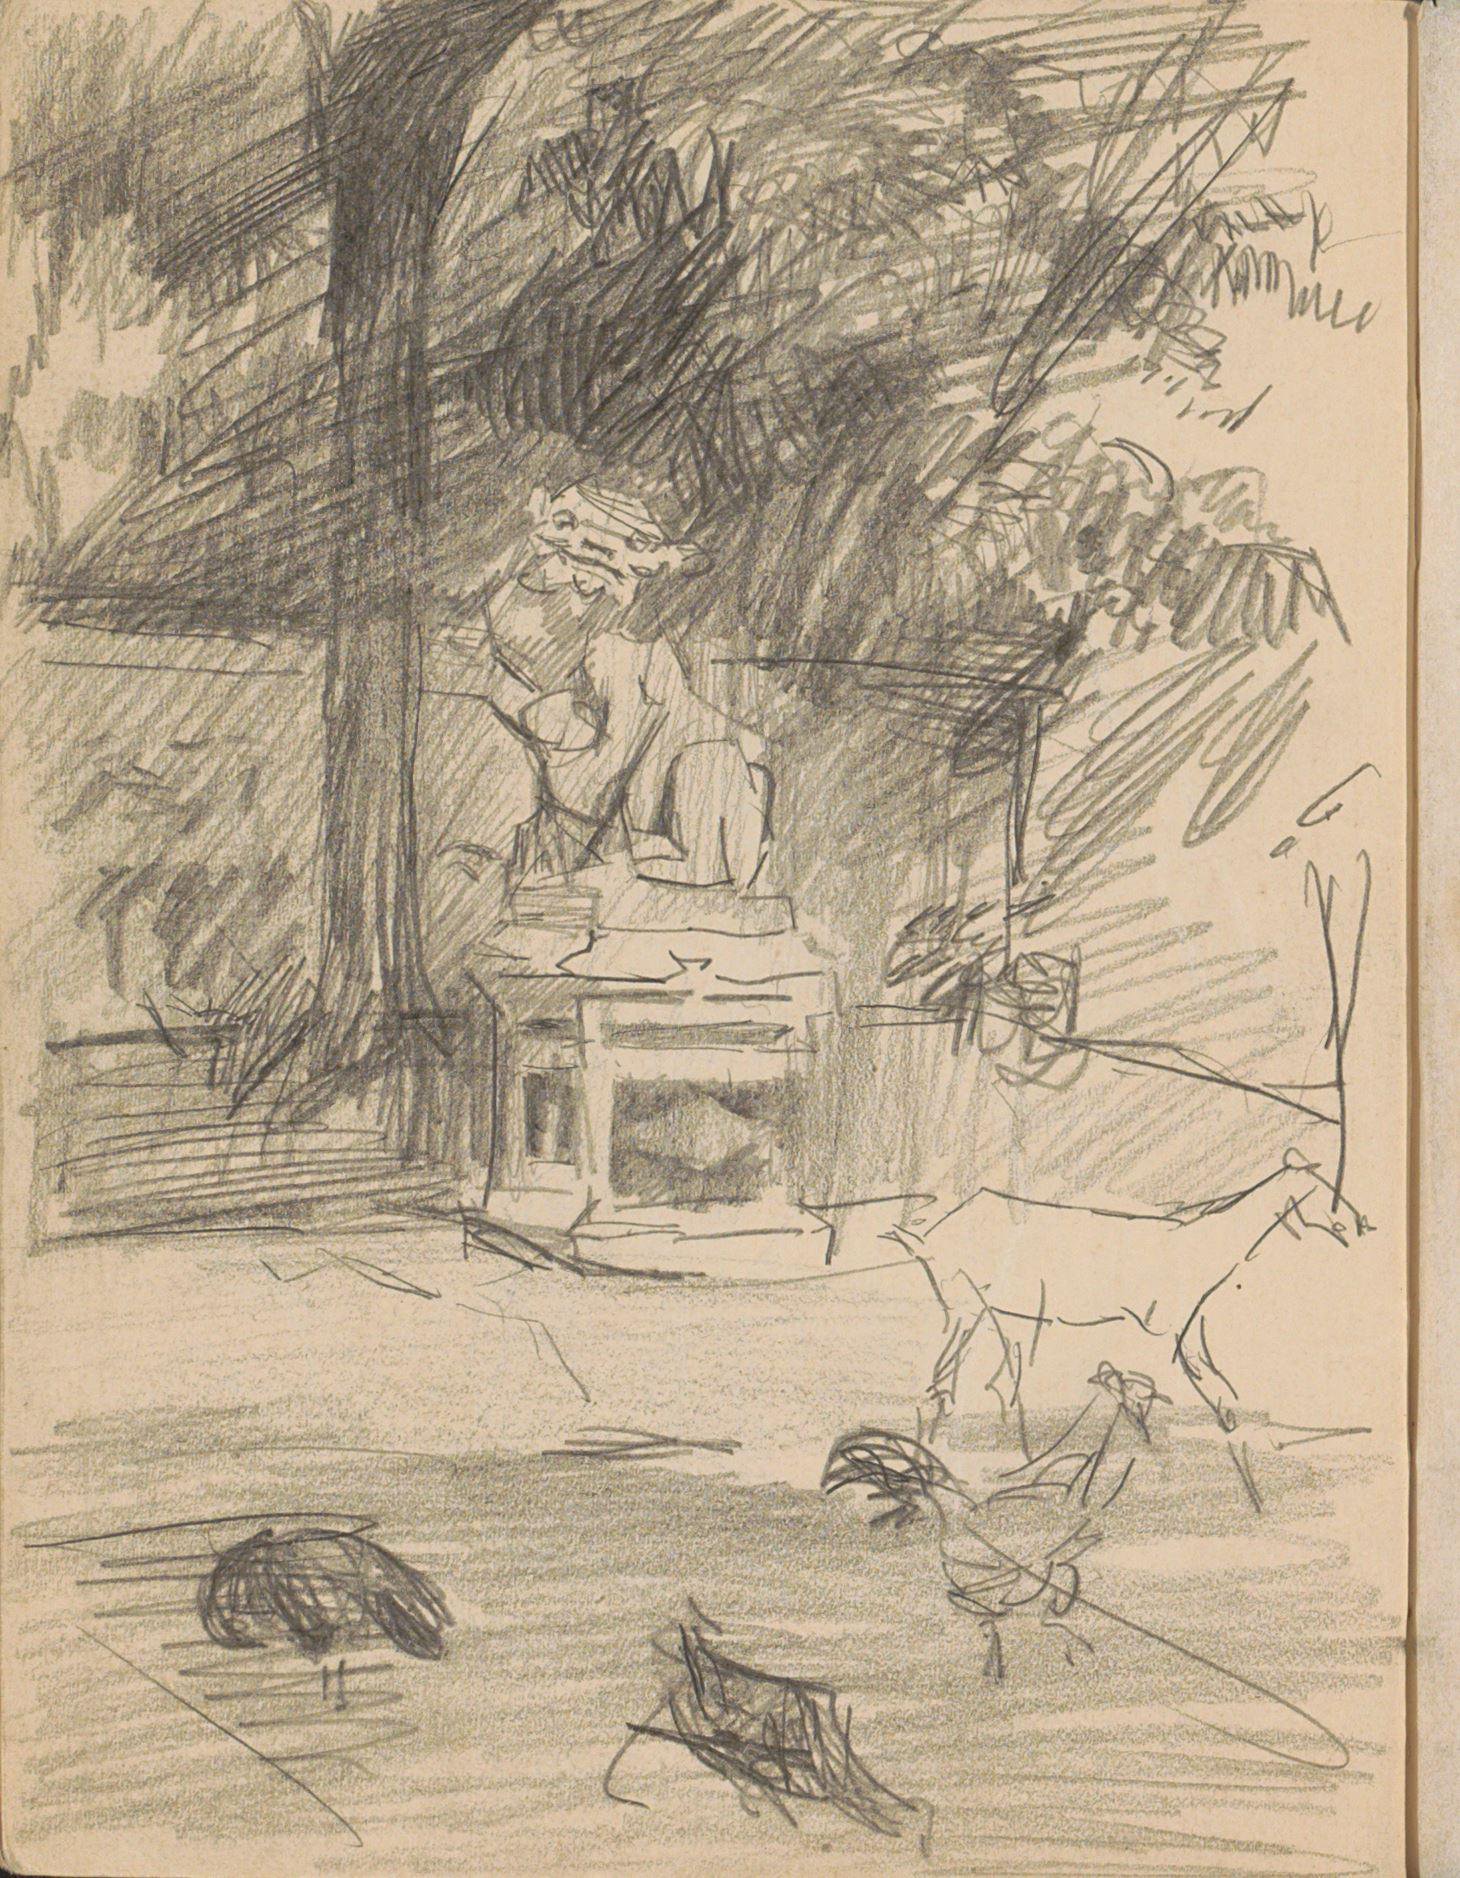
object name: sketchbook leaf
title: Dieren voor een sculptuur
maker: isaac israels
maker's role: draughtsman, painter, print maker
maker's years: 1865-1934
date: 1921-1922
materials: paper, pencil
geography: dutch east indies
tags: fowl (cock, hen, chicken, etc.), sculpture, goat, dutch east indies, the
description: Mogelijk kippen en een geit. Pagina 22 uit schetsboek XXXIV met 24 pagina's.